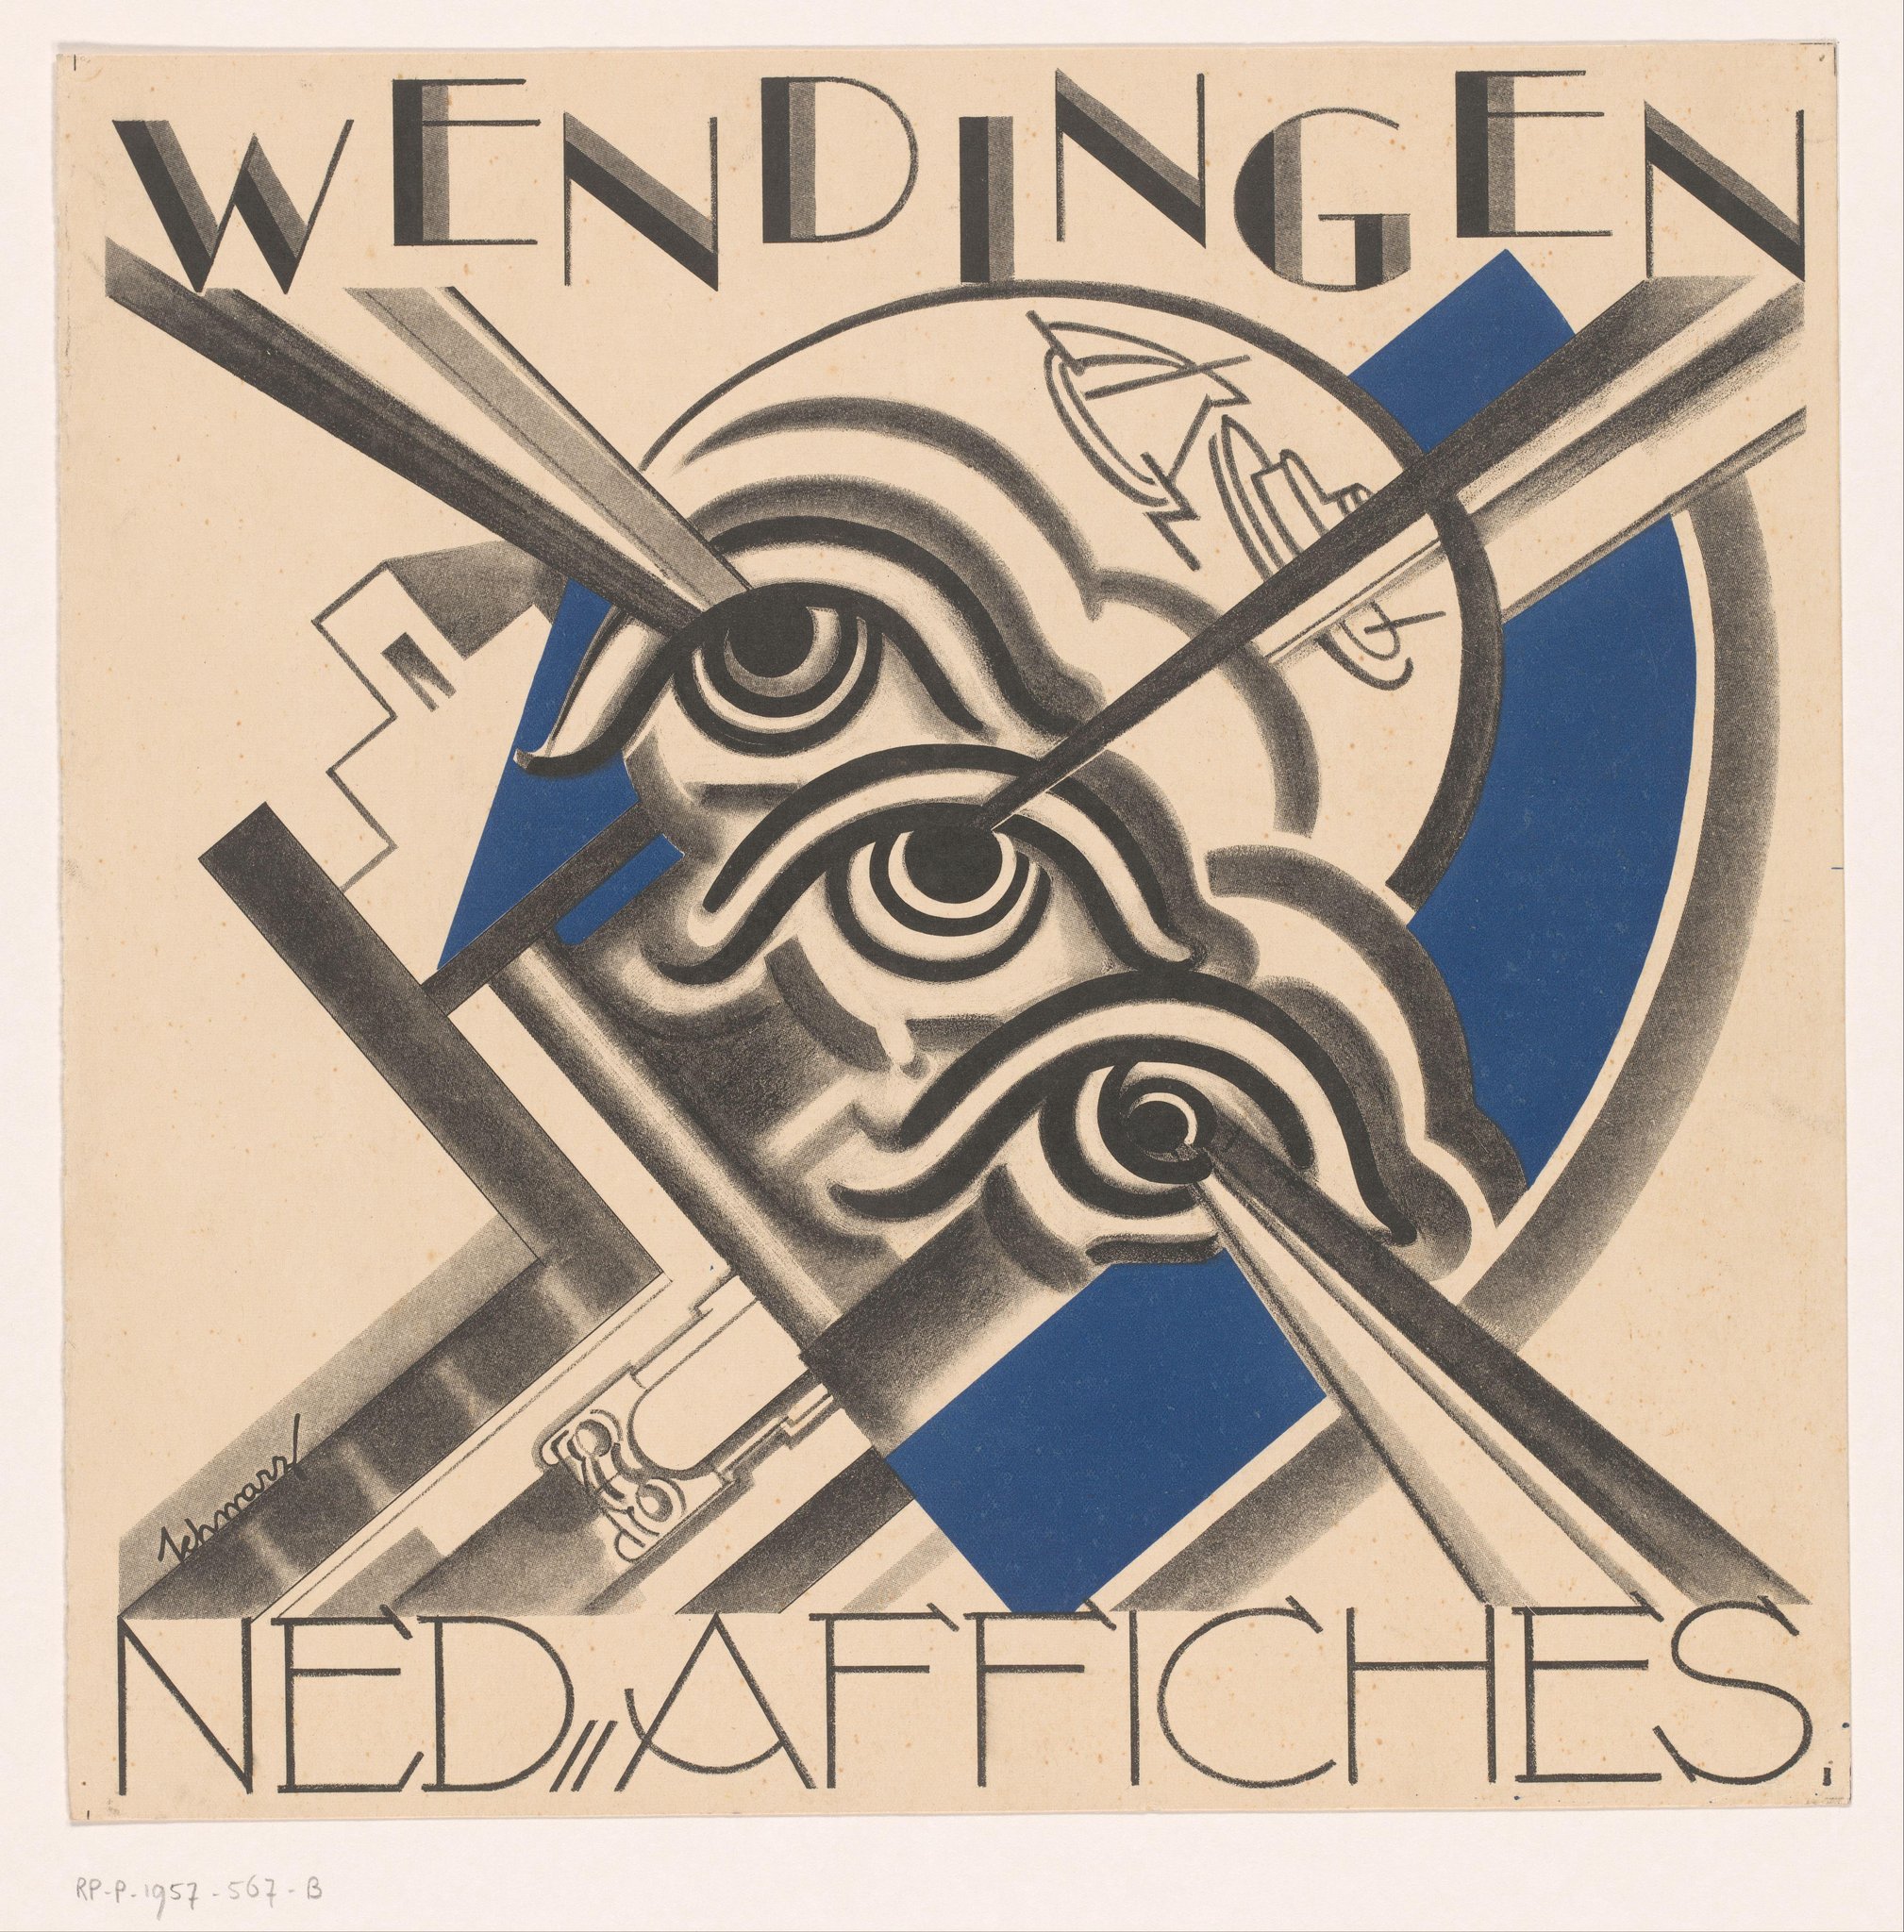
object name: wrapper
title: Omslagontwerp voor: Wendingen, 1931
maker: mommie schwarz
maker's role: print maker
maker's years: 1876-1942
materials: paper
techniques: lithograph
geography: netherlands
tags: eyes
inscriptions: stamp: ‘Instituut voor sier- en nijverheidskunst.’, inscription: ‘Schwarz No. 6112B litho's 1932’, collector's mark: Lugt 2228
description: Prent gebruikt voor: Wendingen. Maandblad voor bouwen en sieren van "Architectura et Amicitia". Amsterdam: De Hooge Brug, 1931, nr. 2, omslag.